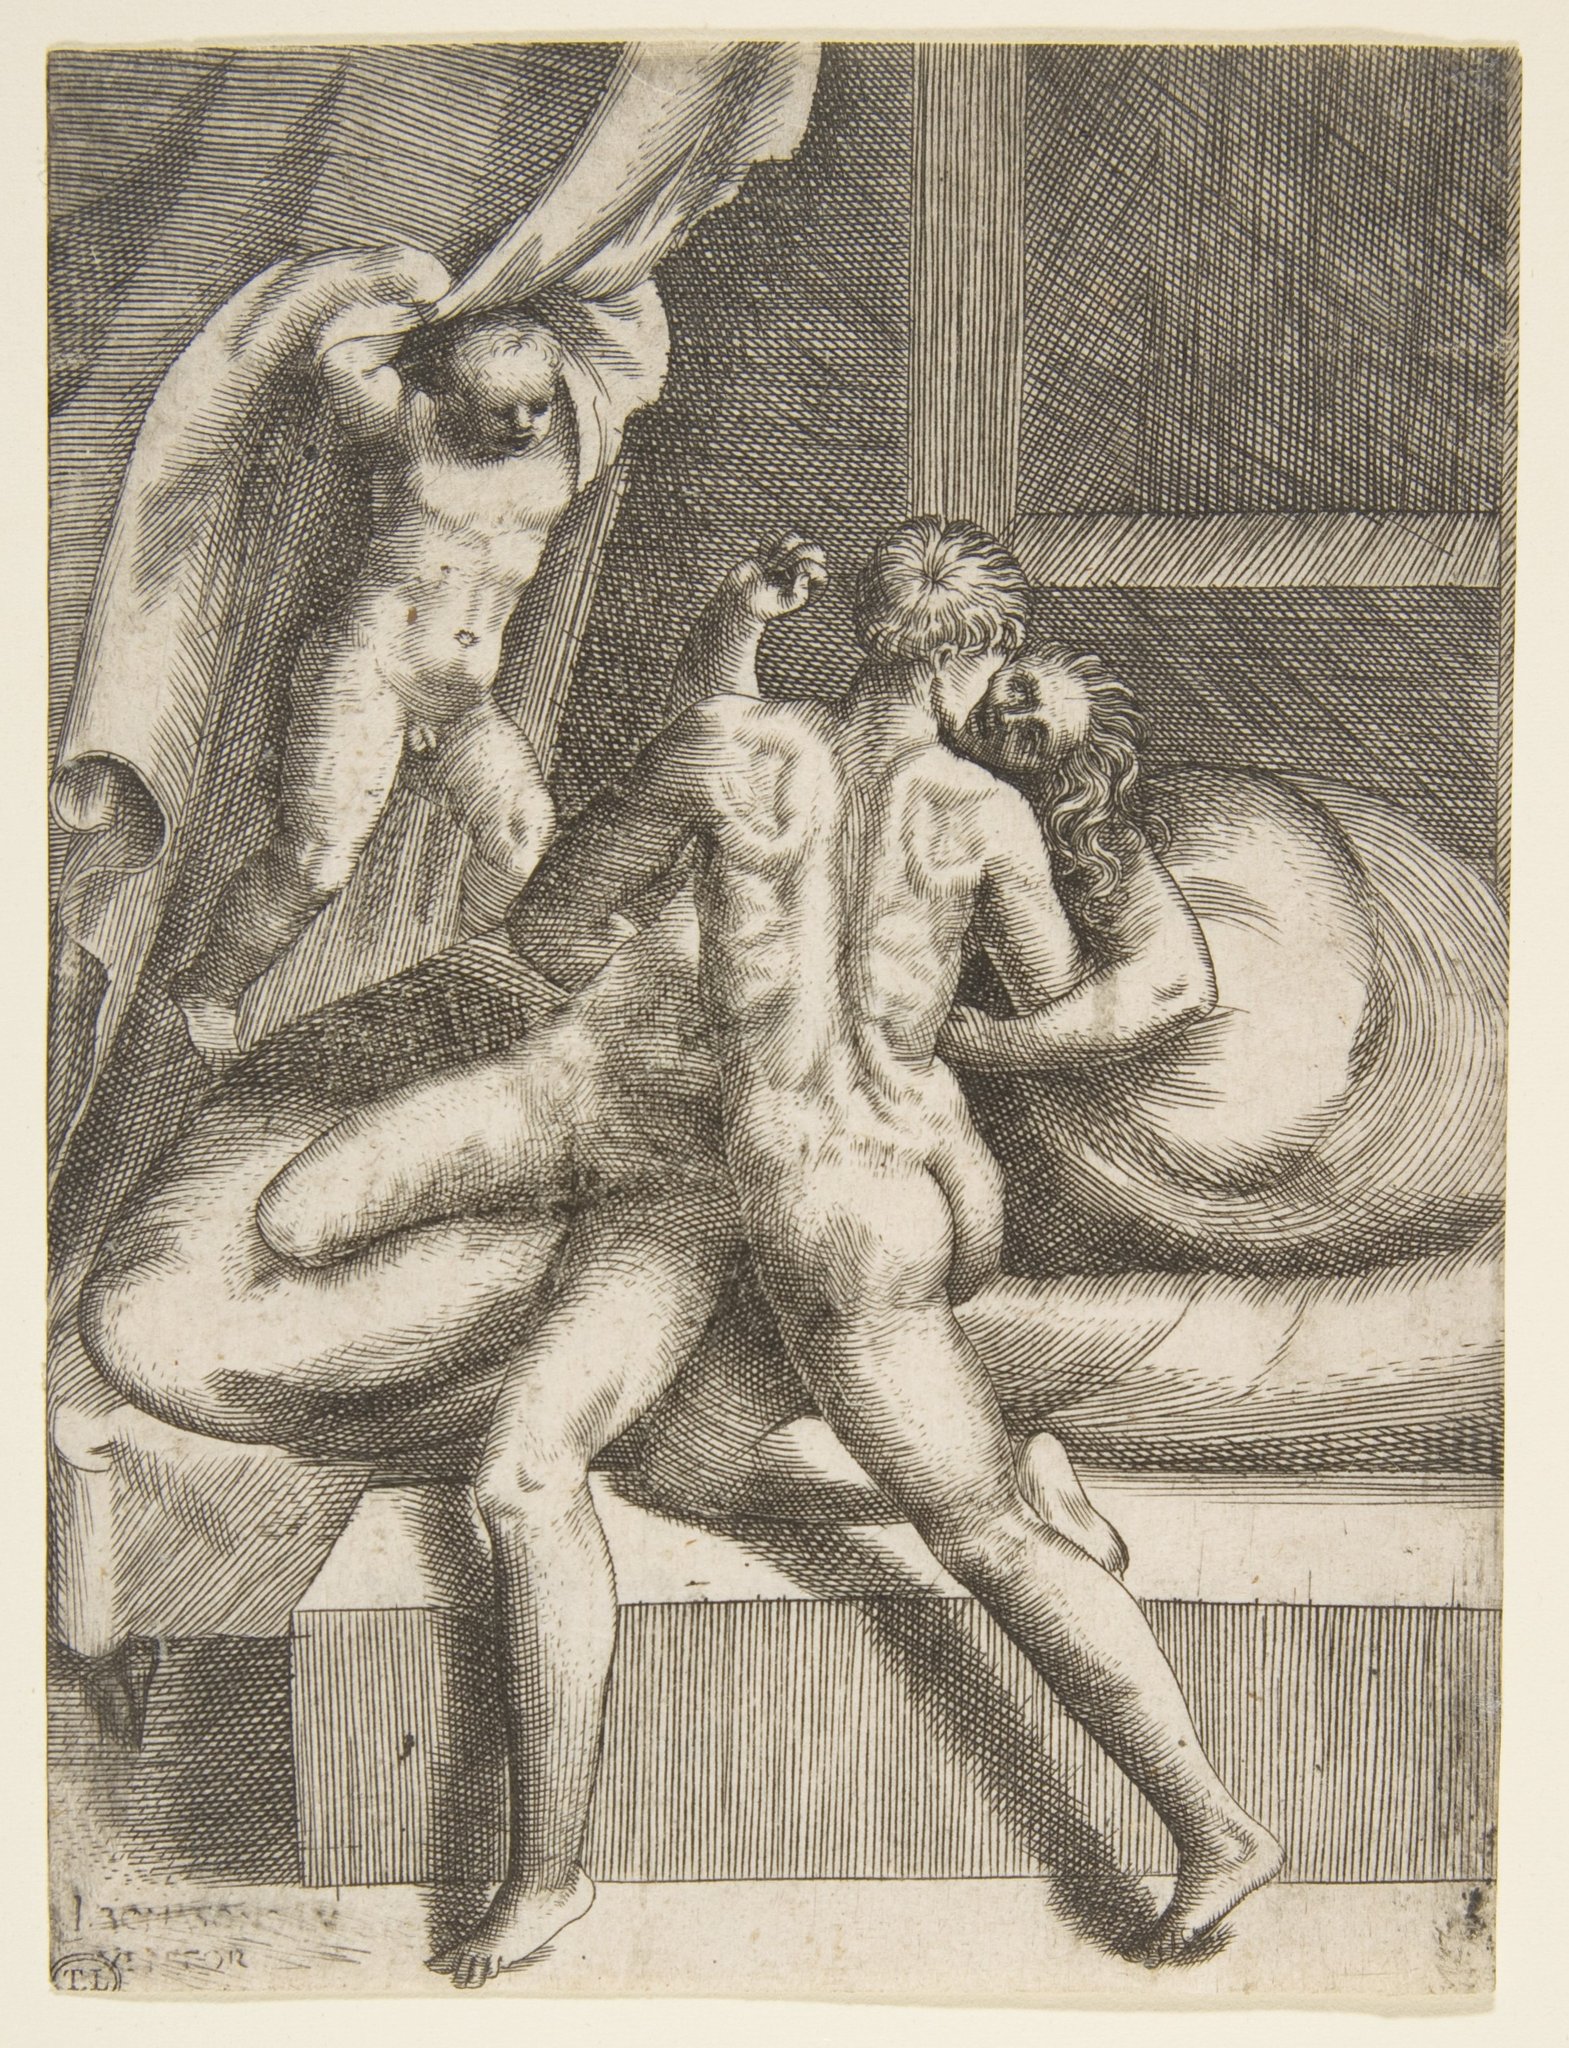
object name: print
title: Apollo and Leucothea, from "The Loves of the Gods"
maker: giulio bonasone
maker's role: artist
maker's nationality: italian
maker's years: 1510-1576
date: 1531-1576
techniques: engraving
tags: children,lovers,apollo,goddess